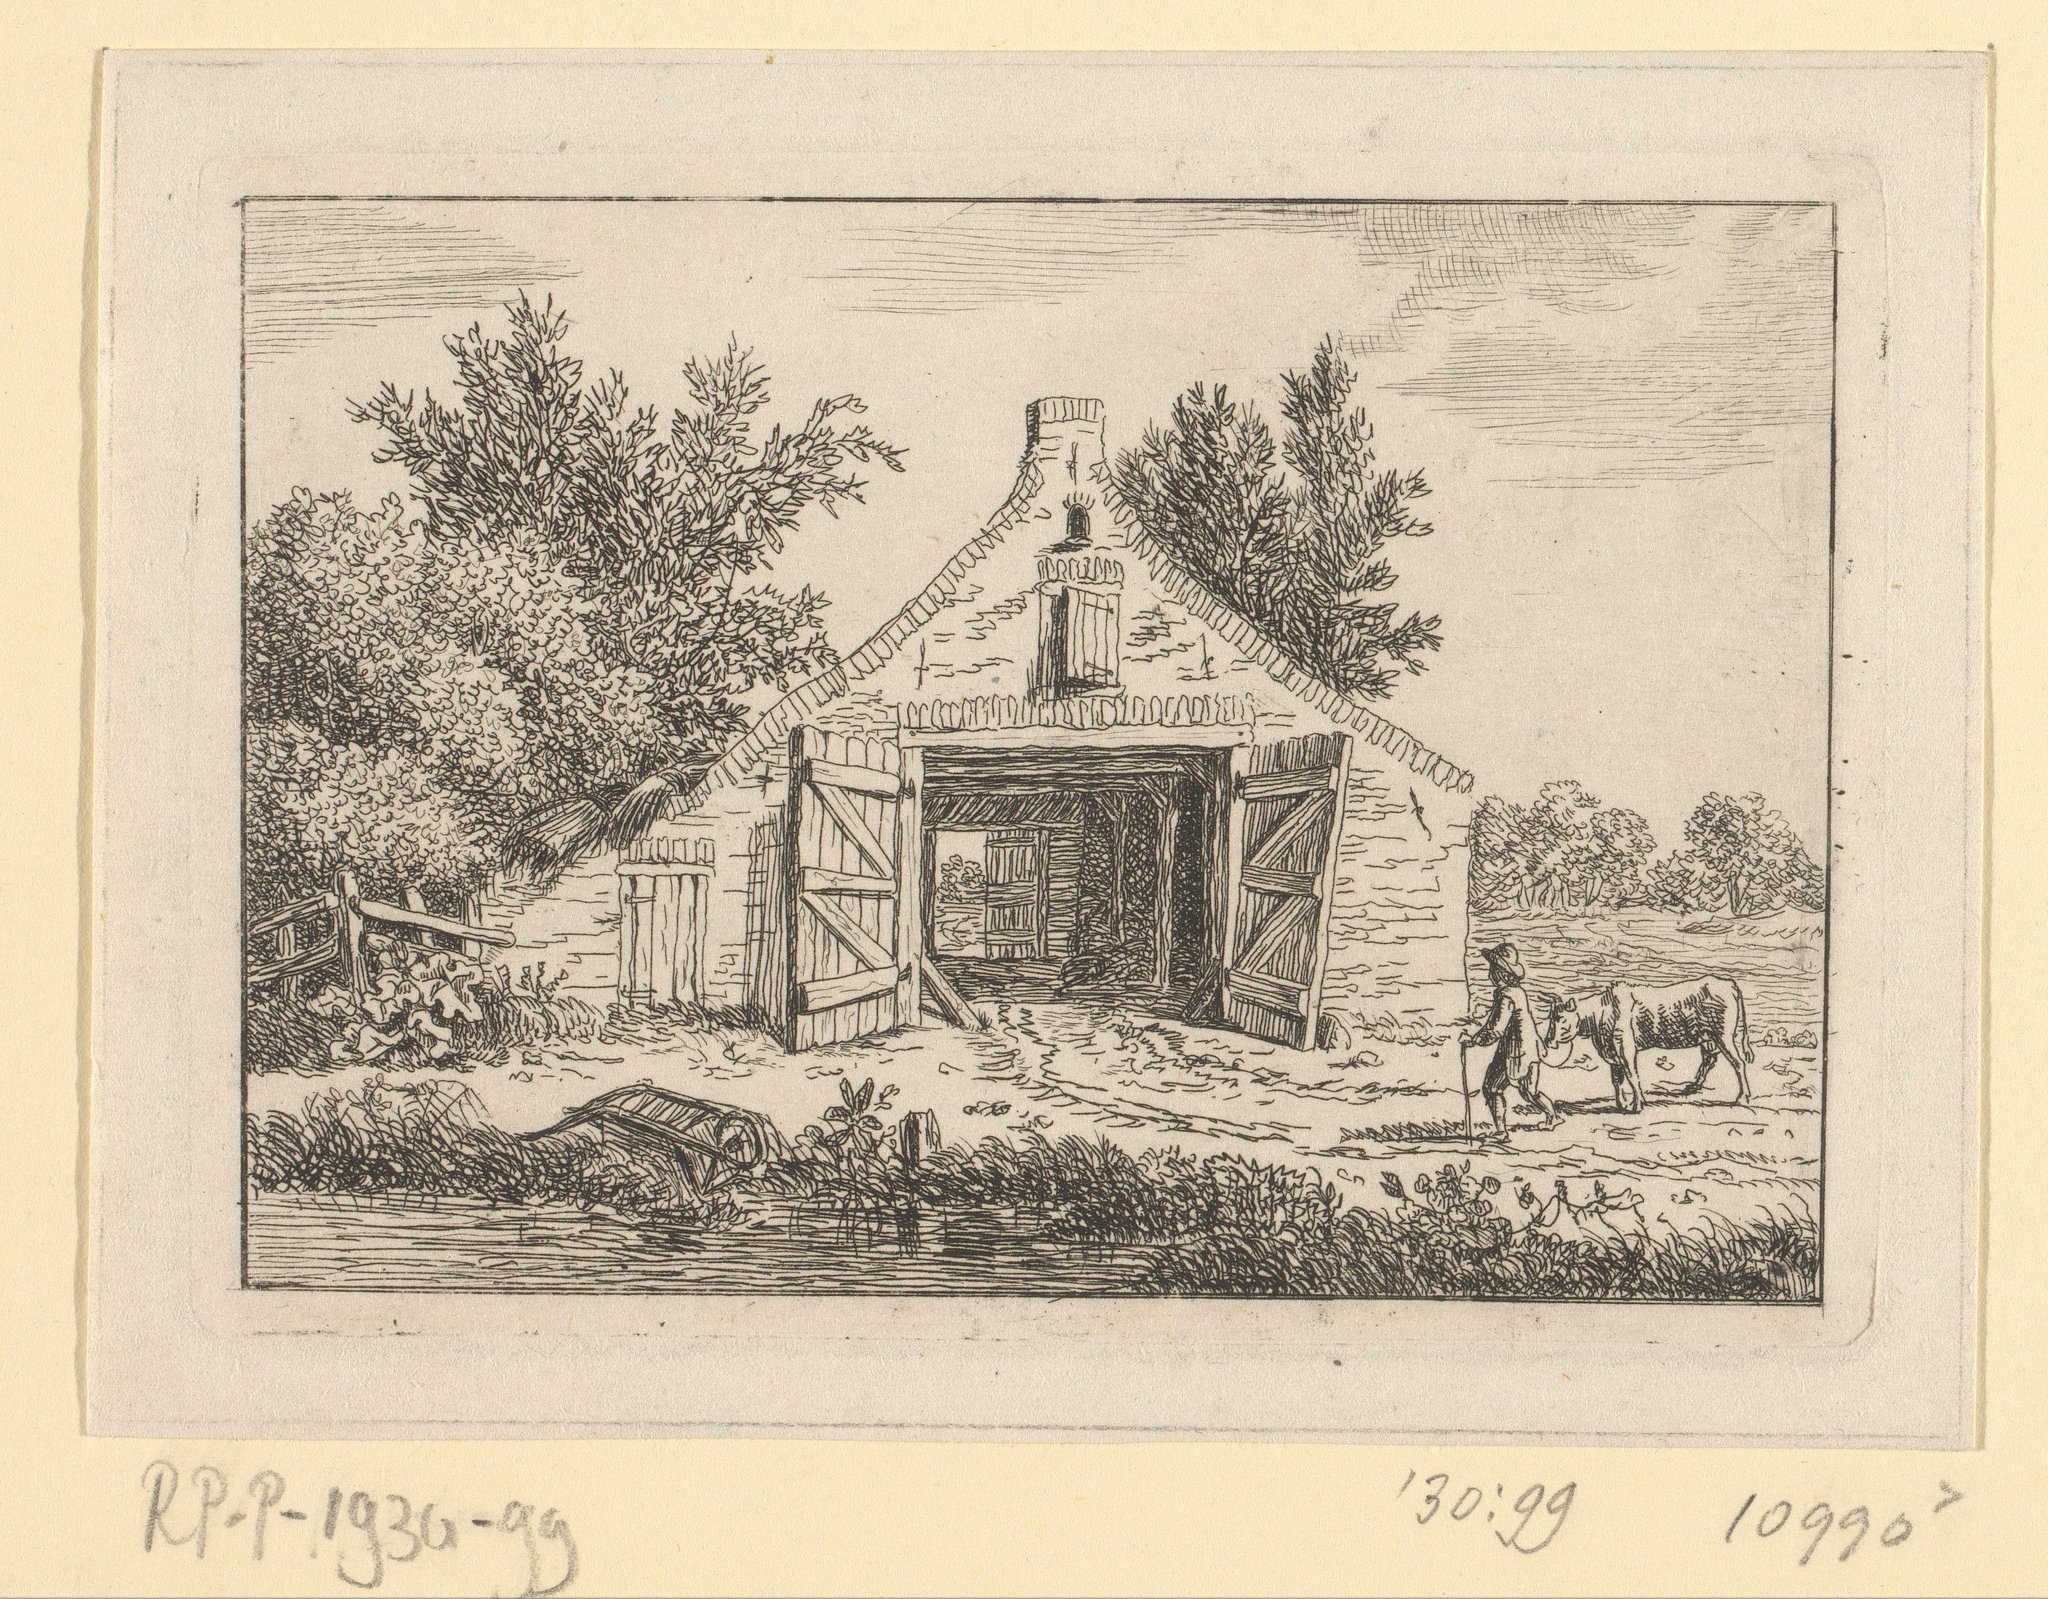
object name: print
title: Man met koe voor een schuur buiten Hattem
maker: anthonie van den bos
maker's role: draughtsman, print maker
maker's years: 1763-1838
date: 1778-1838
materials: paper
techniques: etching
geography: netherlands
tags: cow, farm or solitary house in landscape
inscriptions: collector's mark: Lugt 2233